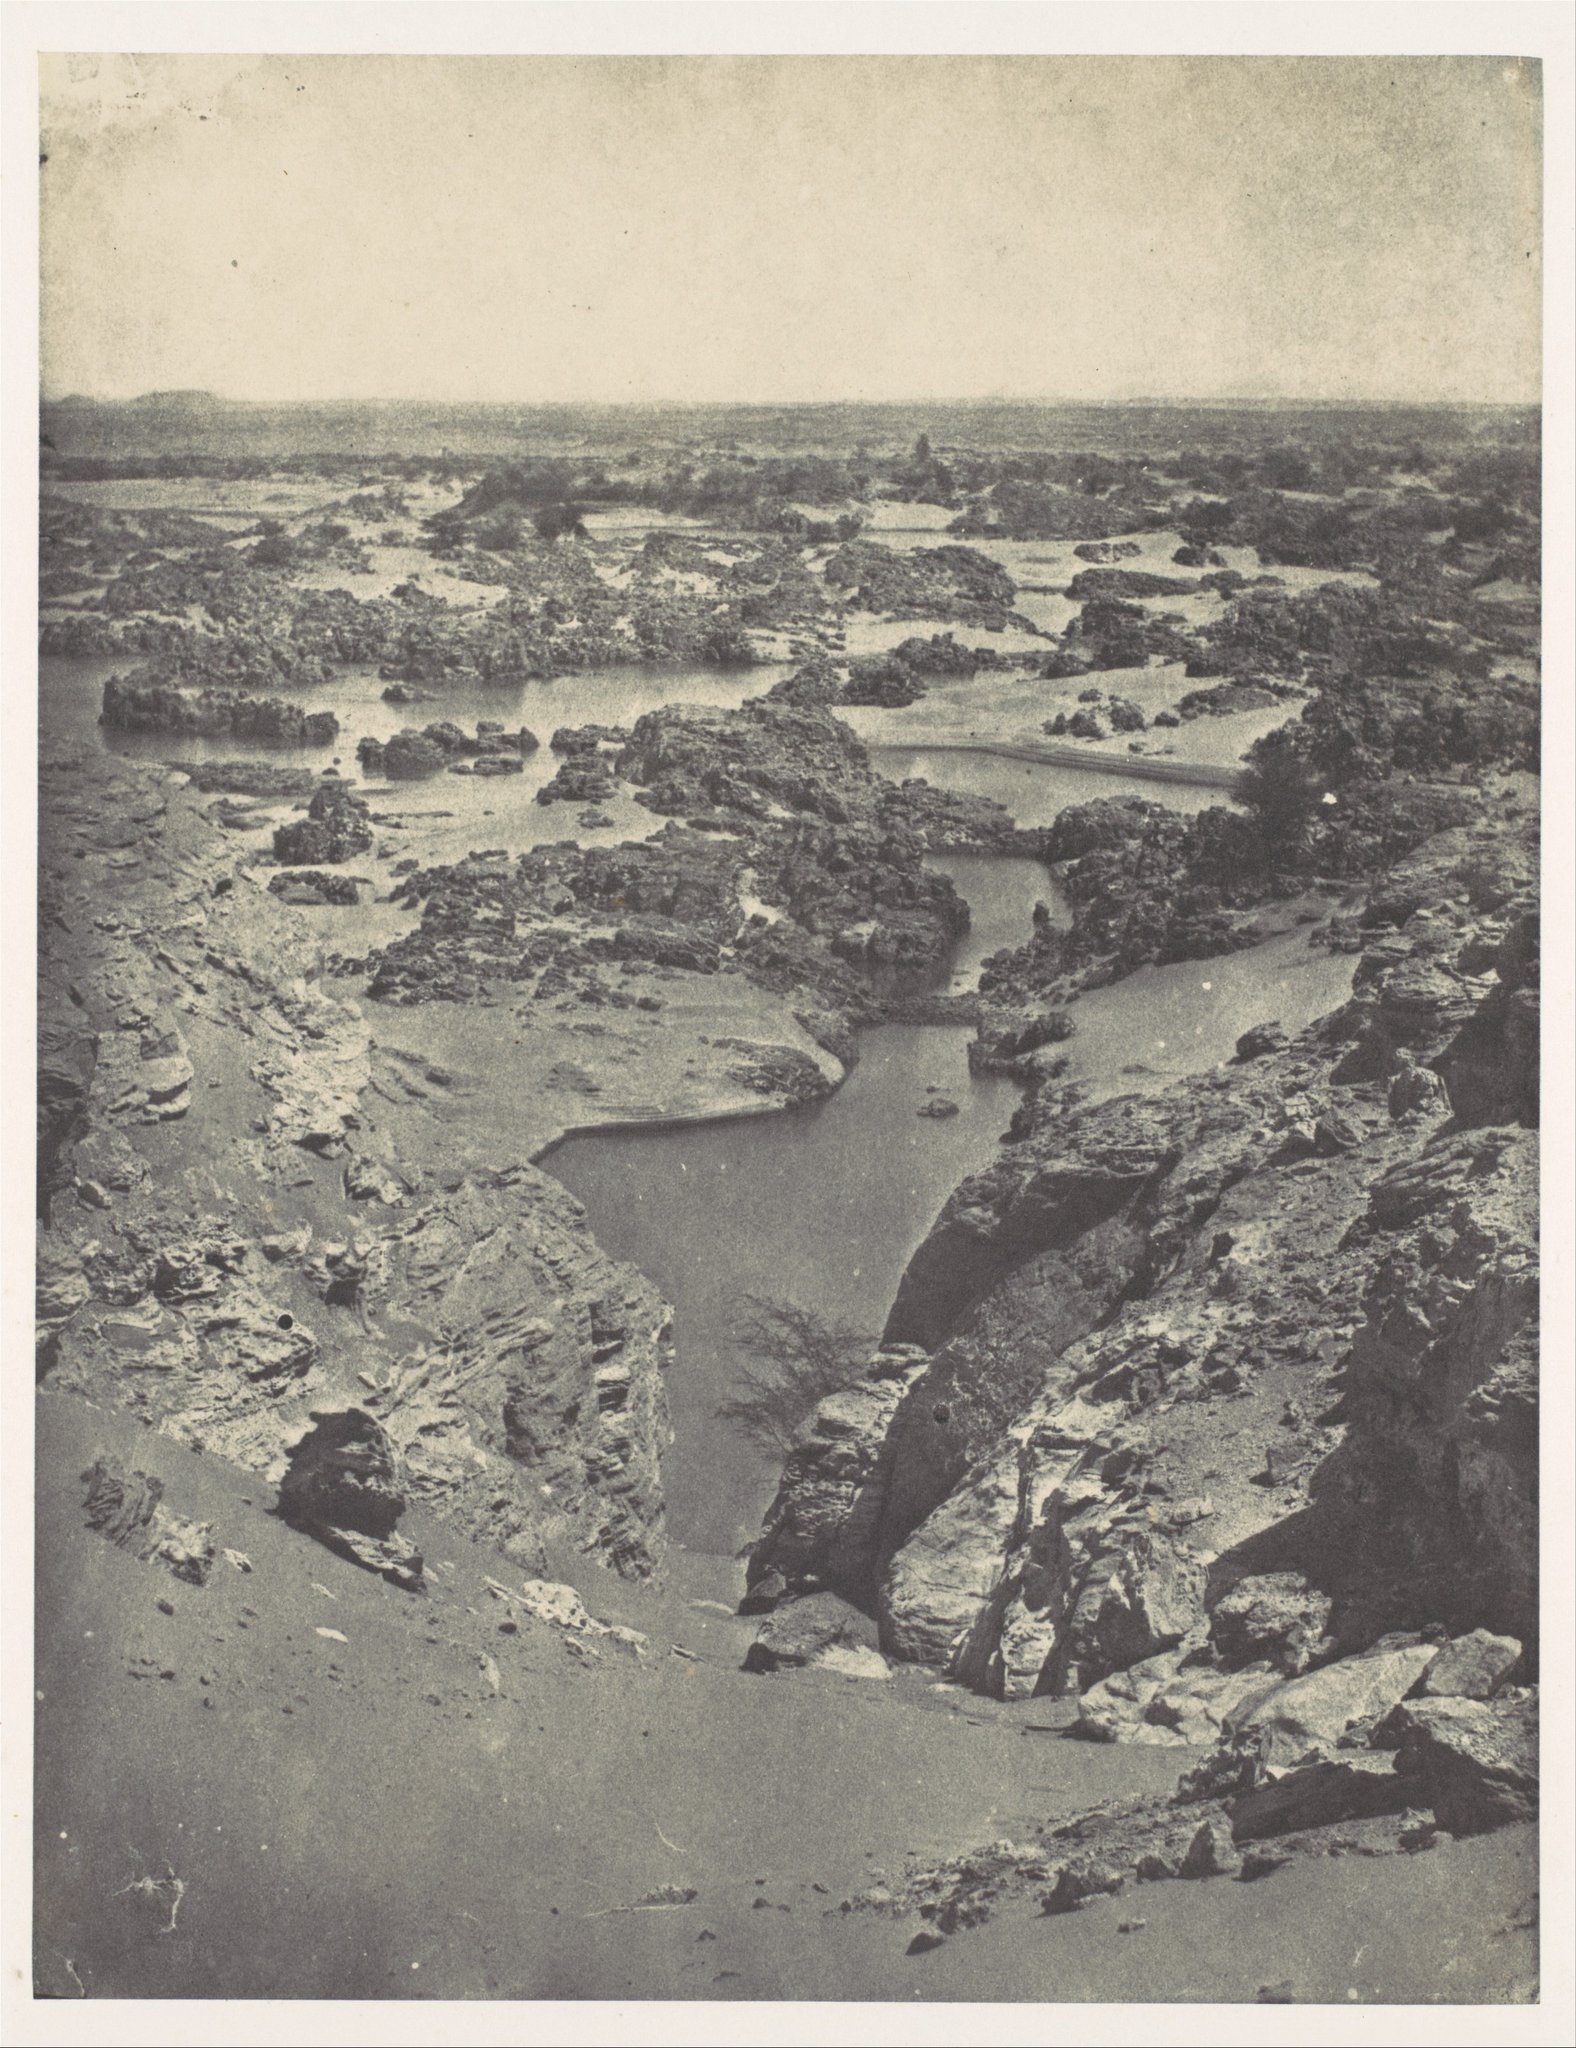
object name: photograph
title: Nubie. Vue Cavalière de la Seconde Cataracte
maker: maxime du camp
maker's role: artist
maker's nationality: french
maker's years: 1822-1894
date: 1850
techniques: paper negative, salted paper print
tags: landscapes